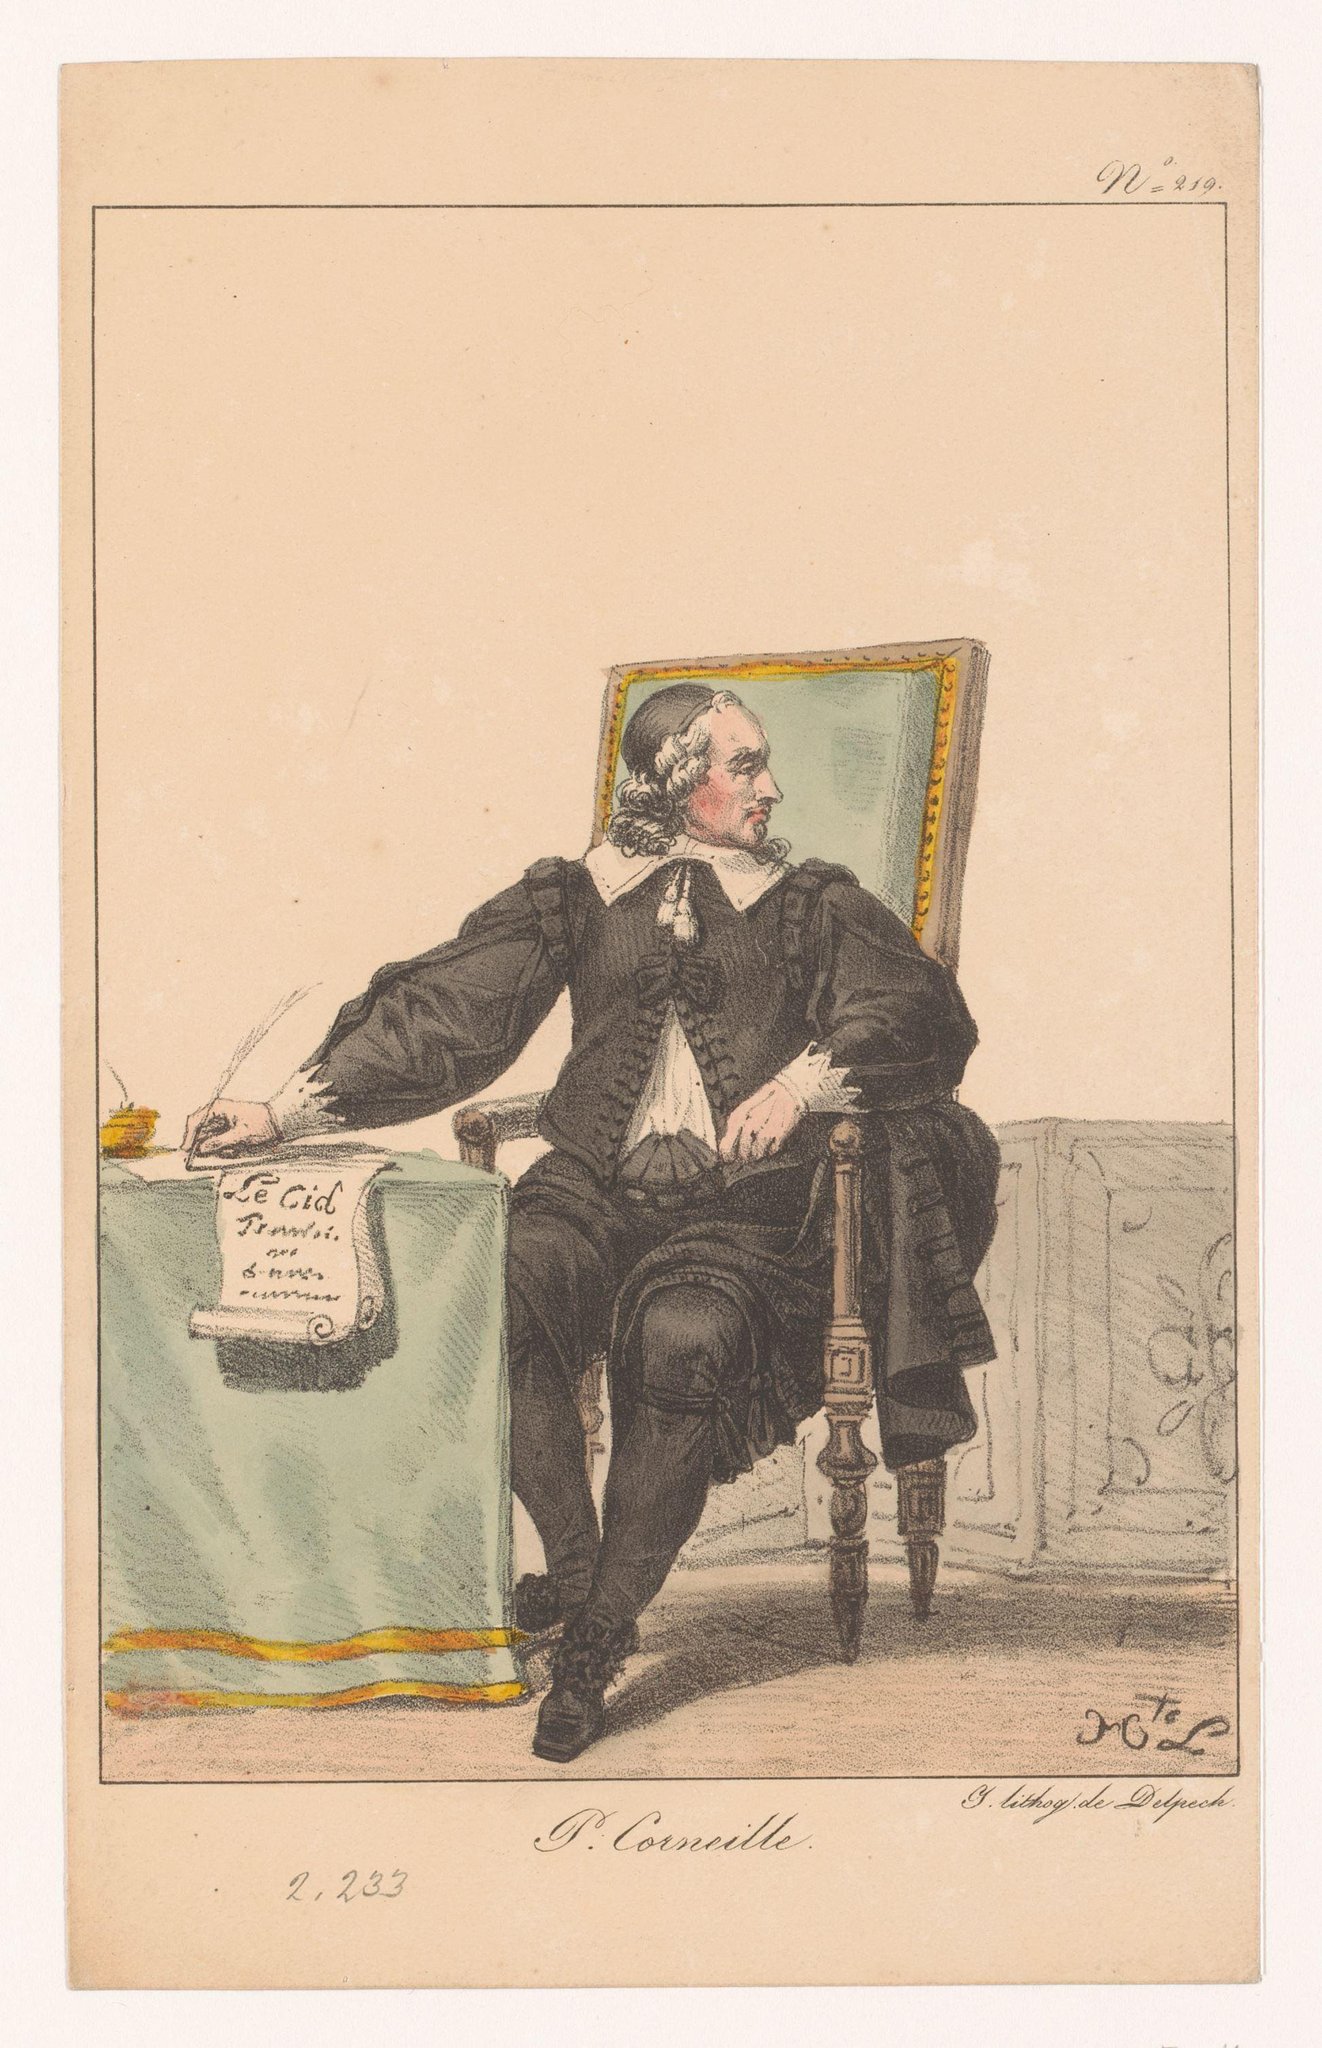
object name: print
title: P. Corneille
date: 1818-1825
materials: paper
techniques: hand coloring, lithograph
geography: paris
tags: pierre corneille, historical persons, writer, poet, author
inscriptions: collector's mark: Lugt 2228a